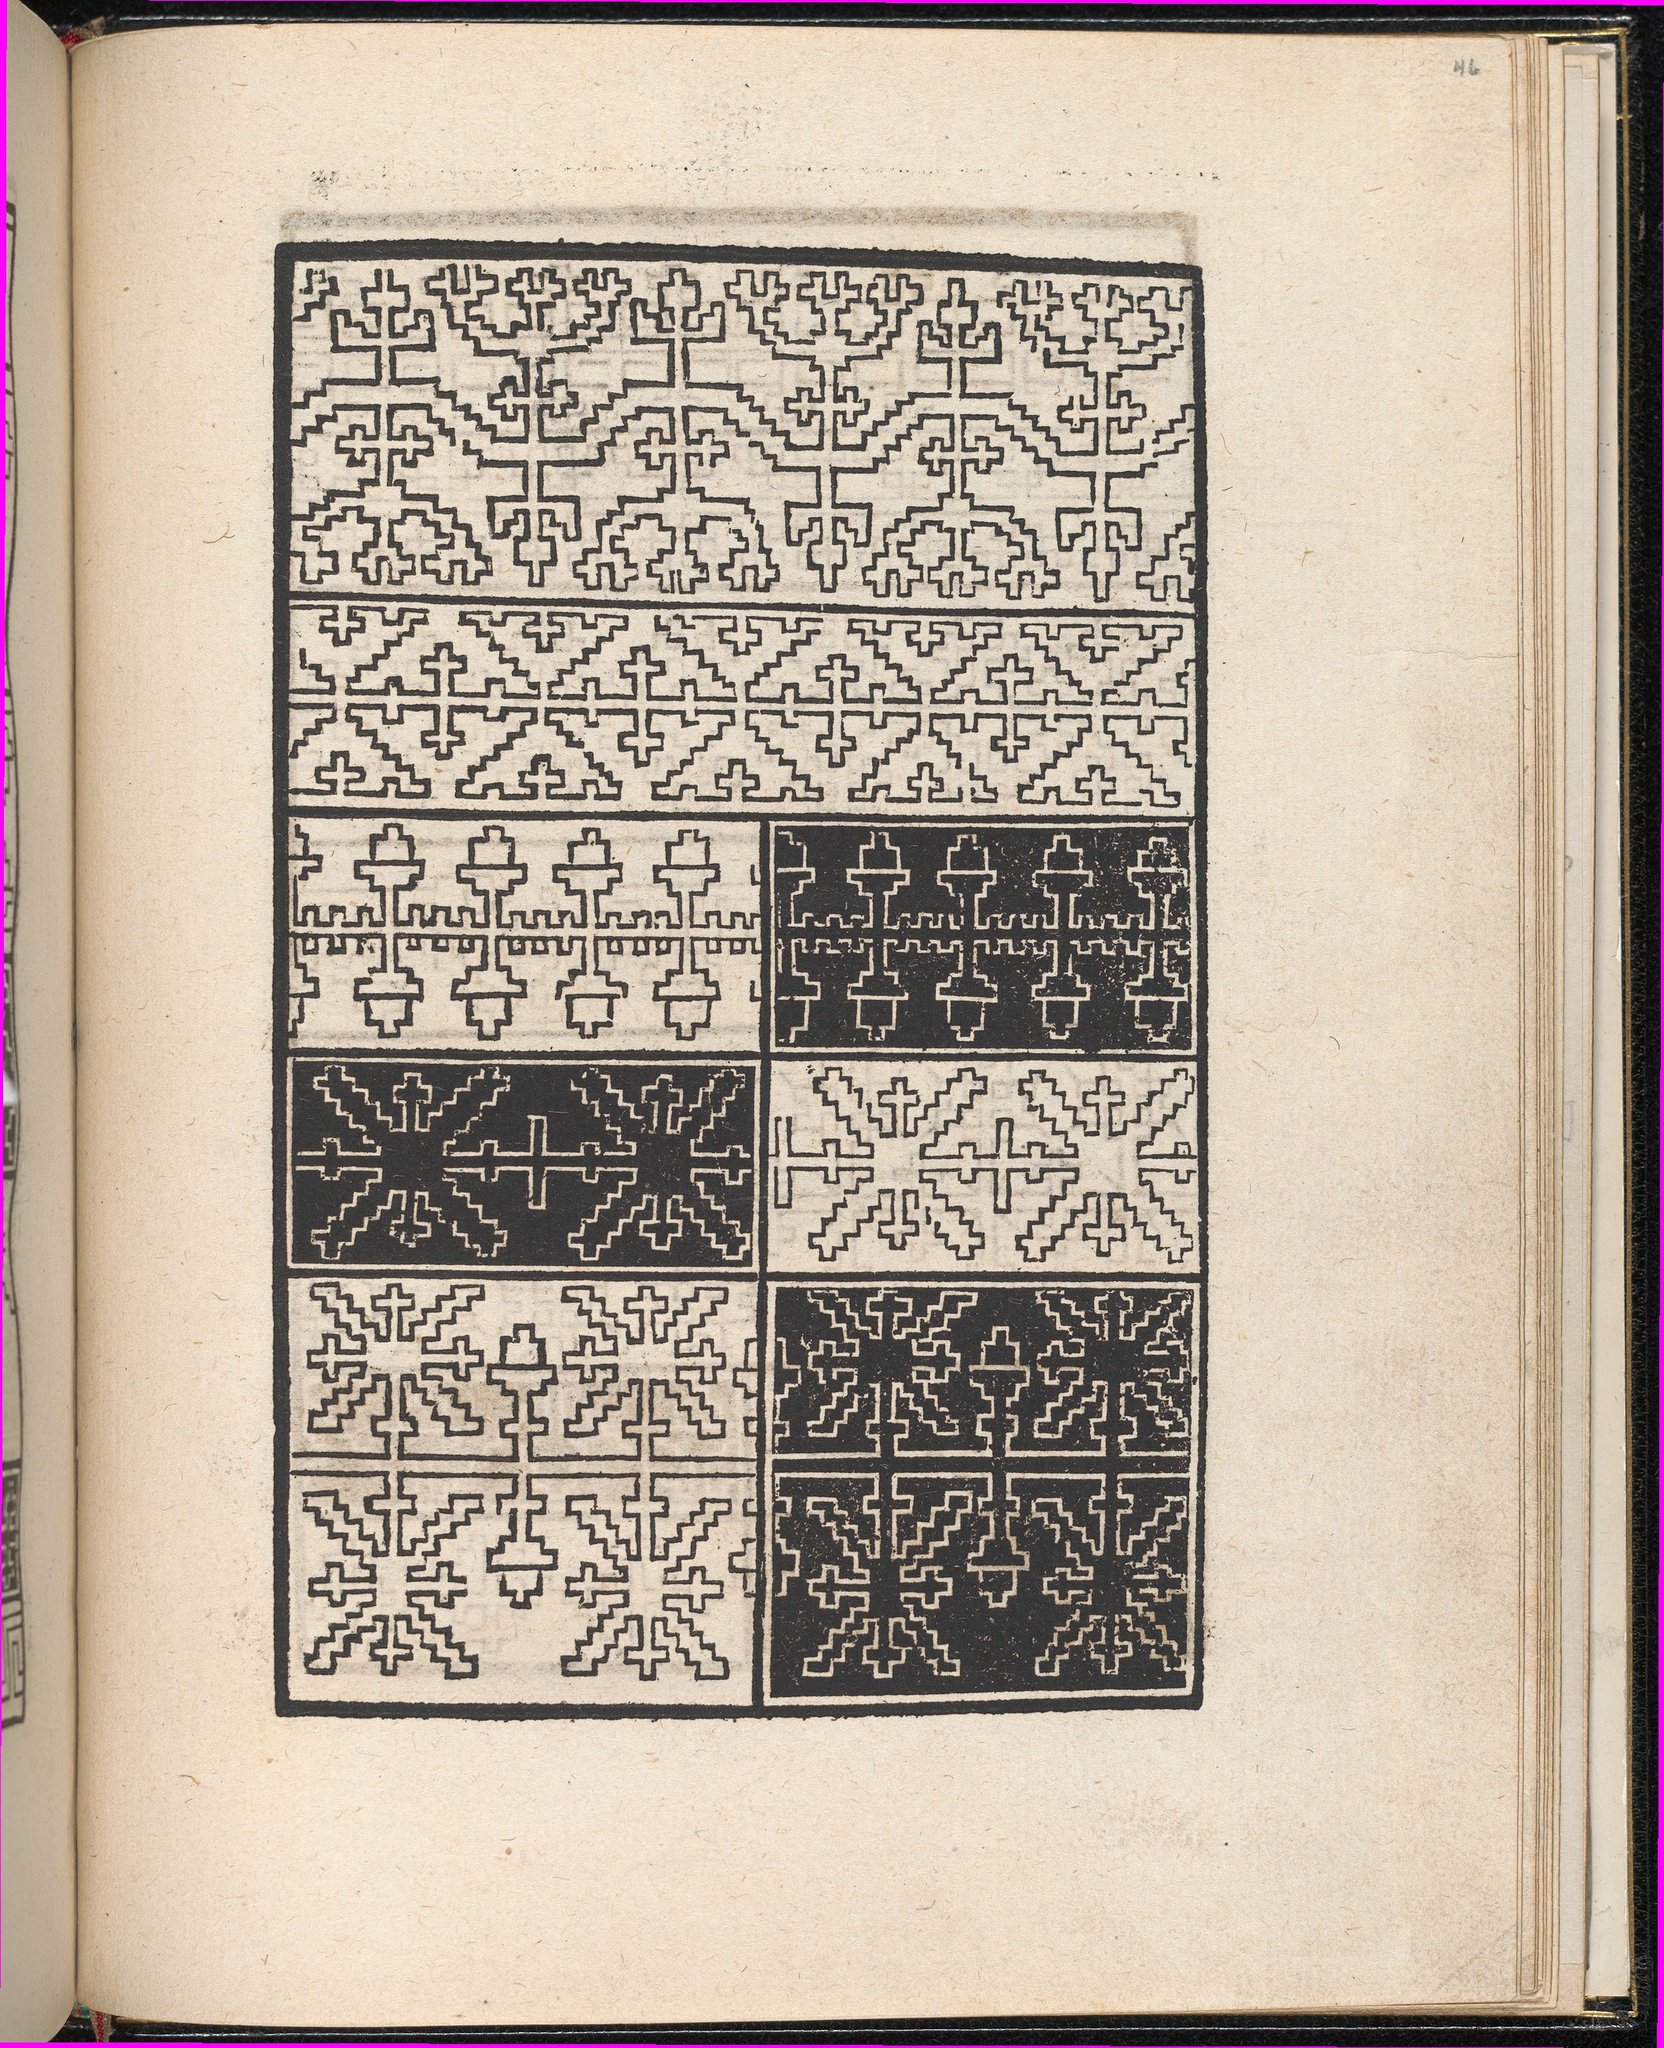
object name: book print ornament architecture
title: Page from Ein new kunstlich Modelbuch...(Page 46r)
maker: peter quentel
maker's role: publisher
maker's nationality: german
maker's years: 1500-1550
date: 1544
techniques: woodcut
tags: ornament